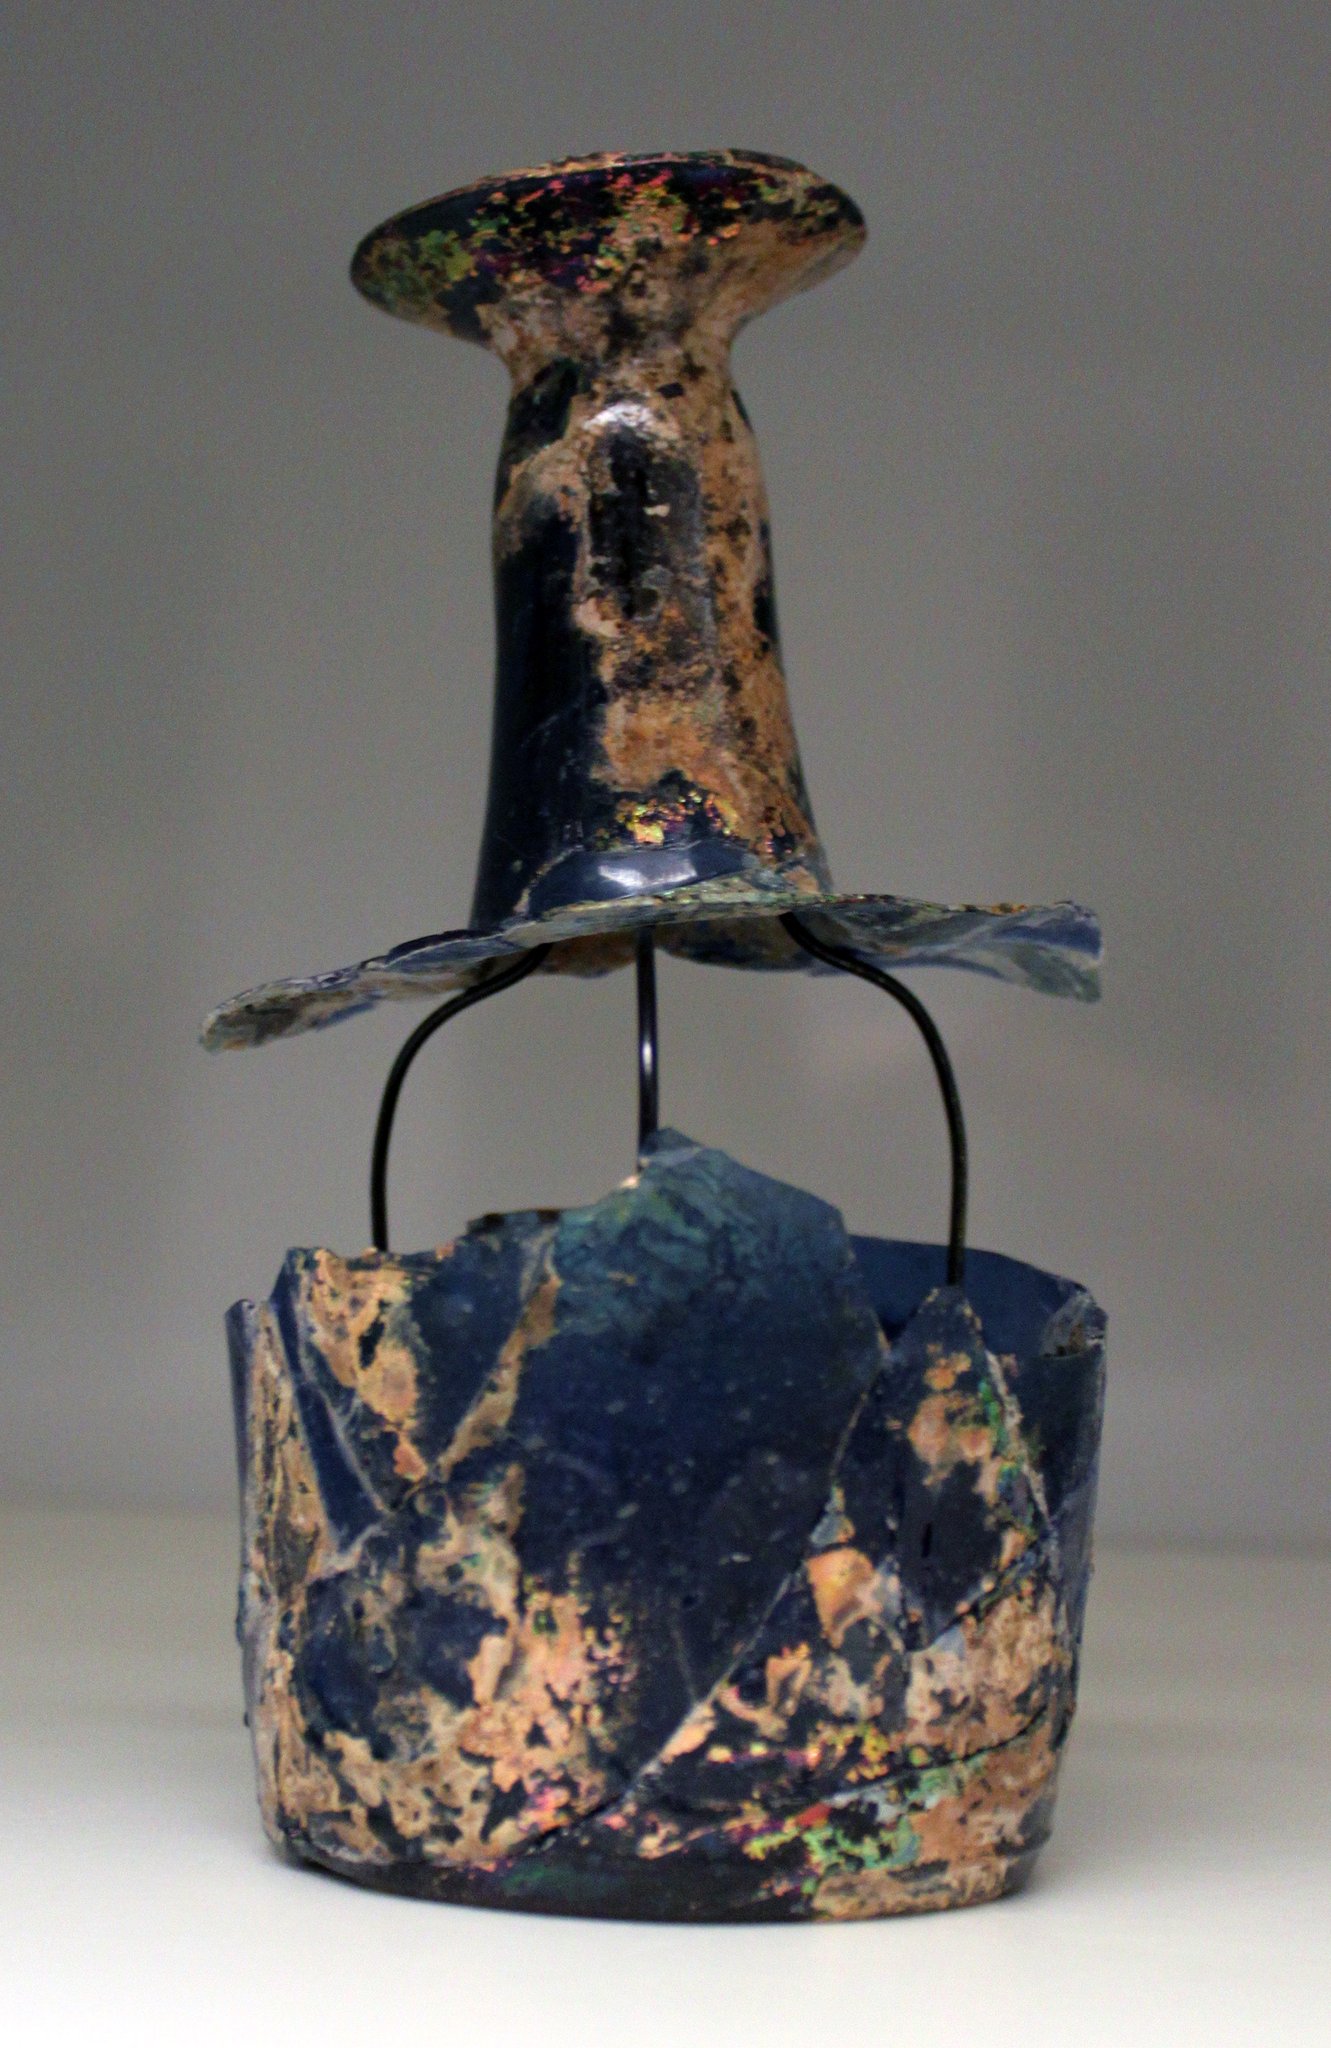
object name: bottle fragment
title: Bottle Fragments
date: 901-1000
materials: glass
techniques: glassblowing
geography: iran